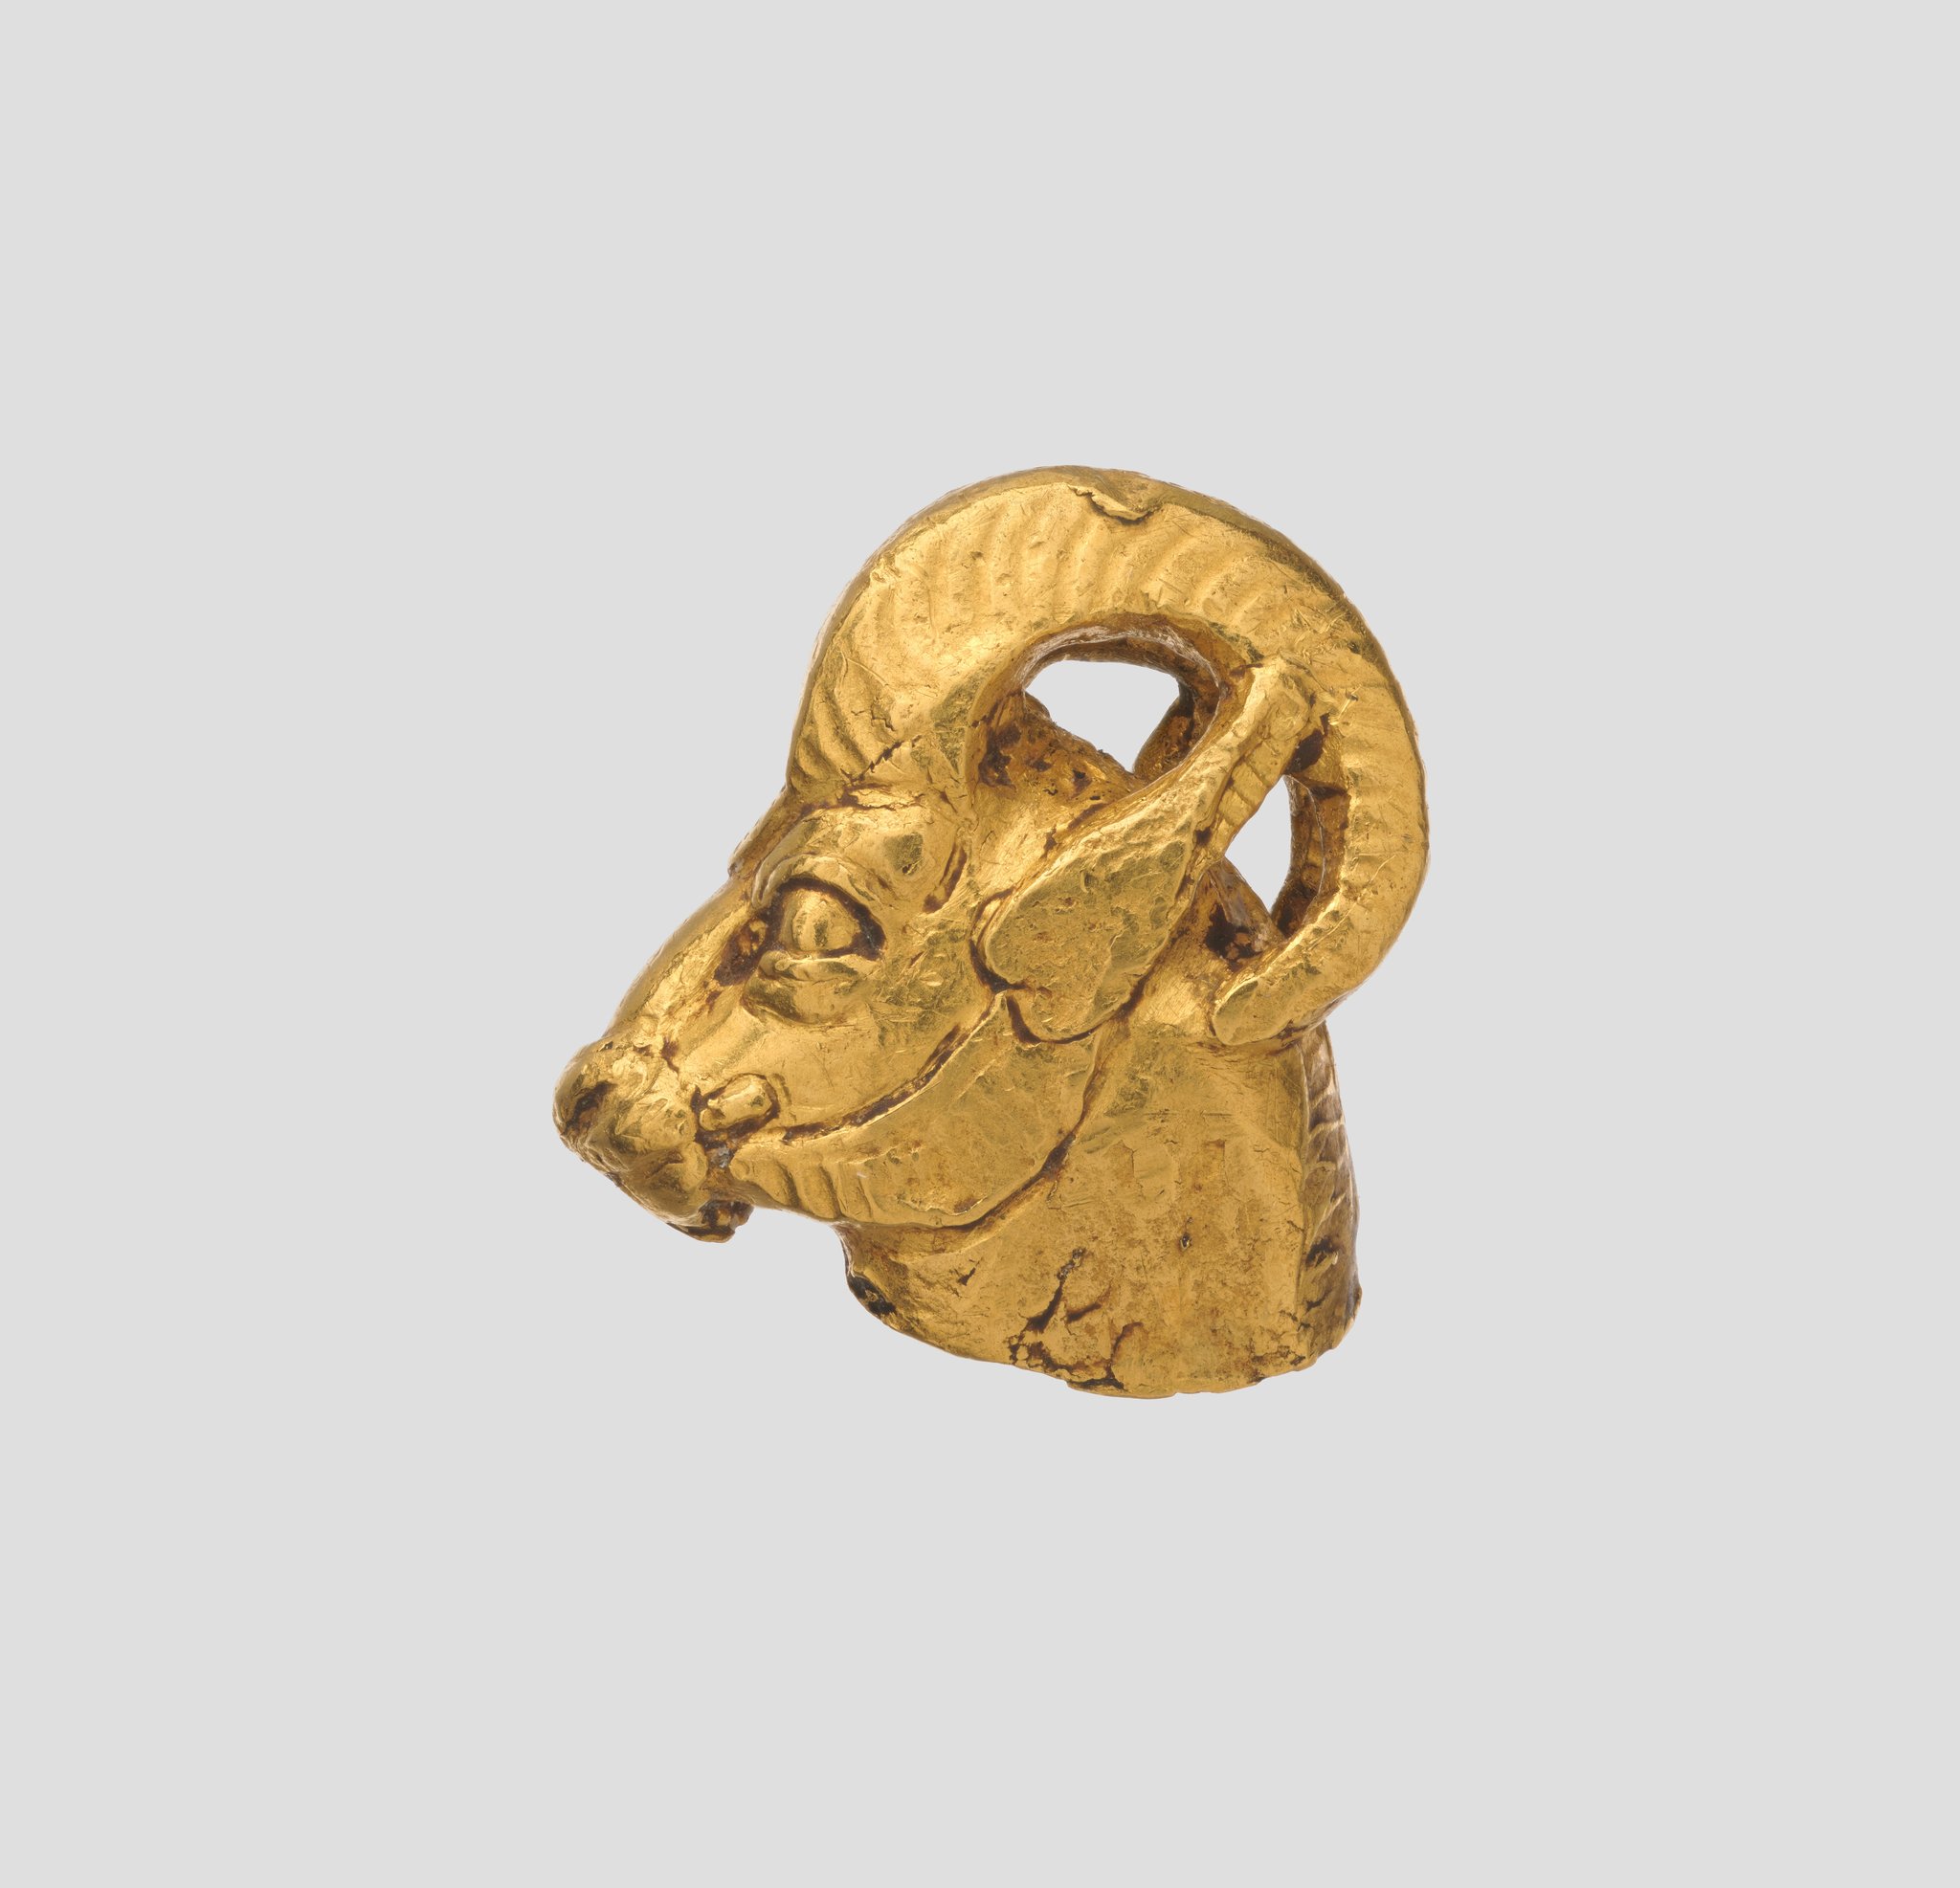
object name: sculpture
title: Head of a wild ram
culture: achaemenid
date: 600-301 BCE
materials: gold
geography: iran (?)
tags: rams